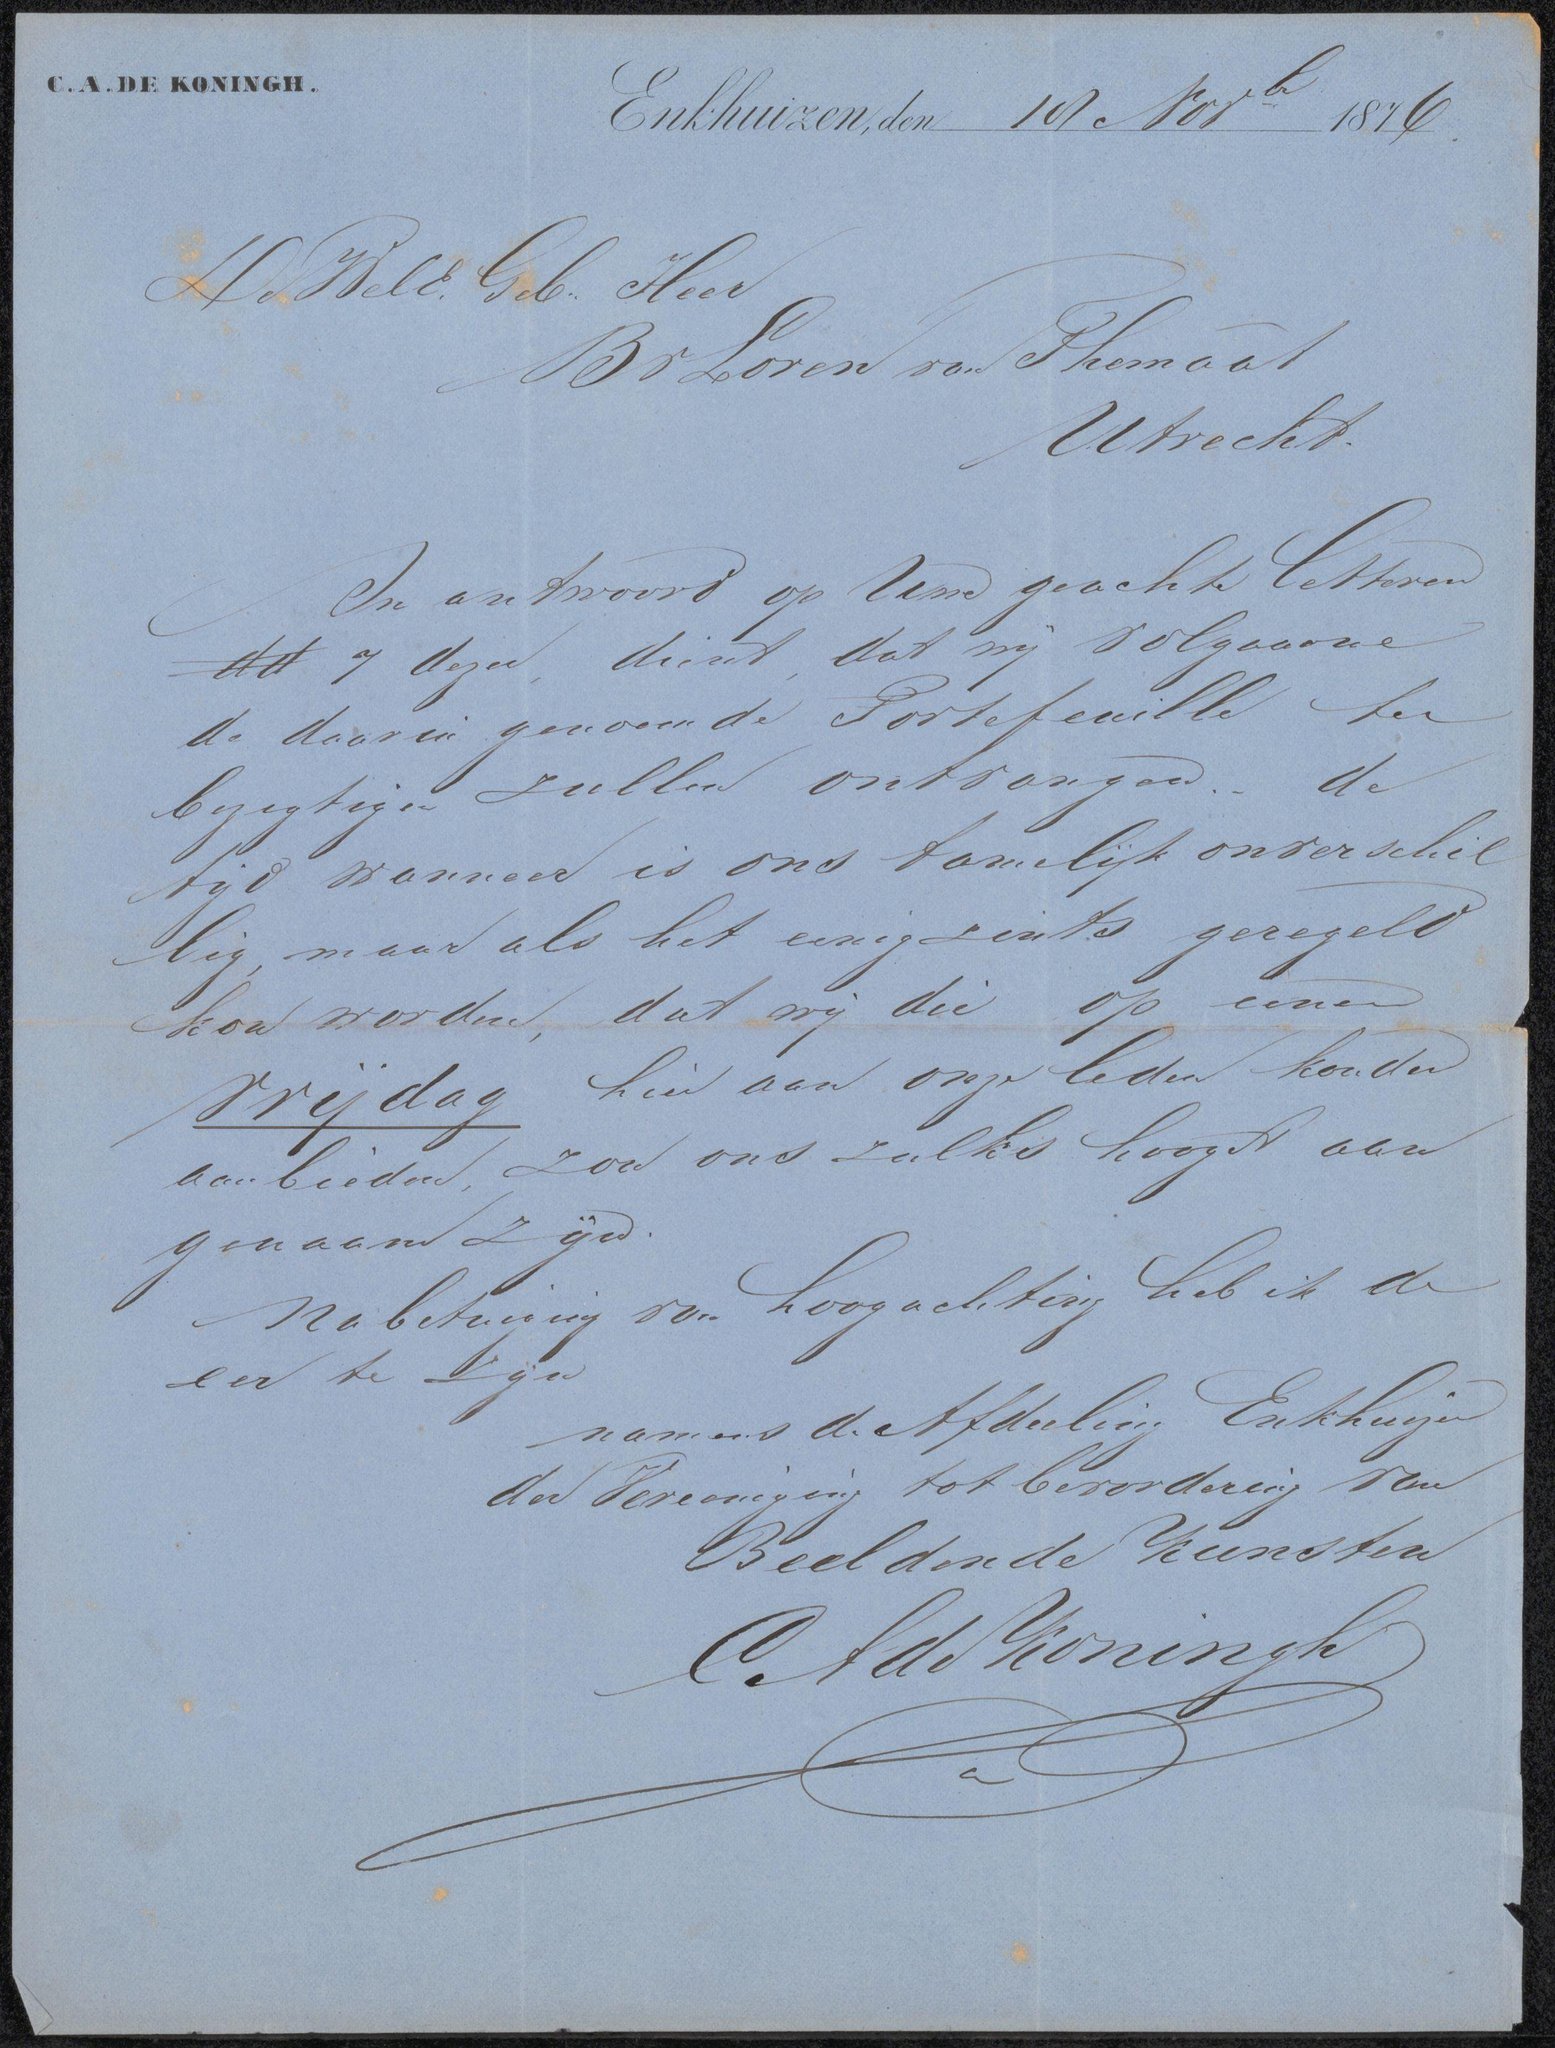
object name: letter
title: Brief aan Pieter Verloren van Themaat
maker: c.a. de koningh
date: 1876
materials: ink, paper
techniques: pen, printing, writing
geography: enkhuizen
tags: utrecht, pieter verloren van themaat